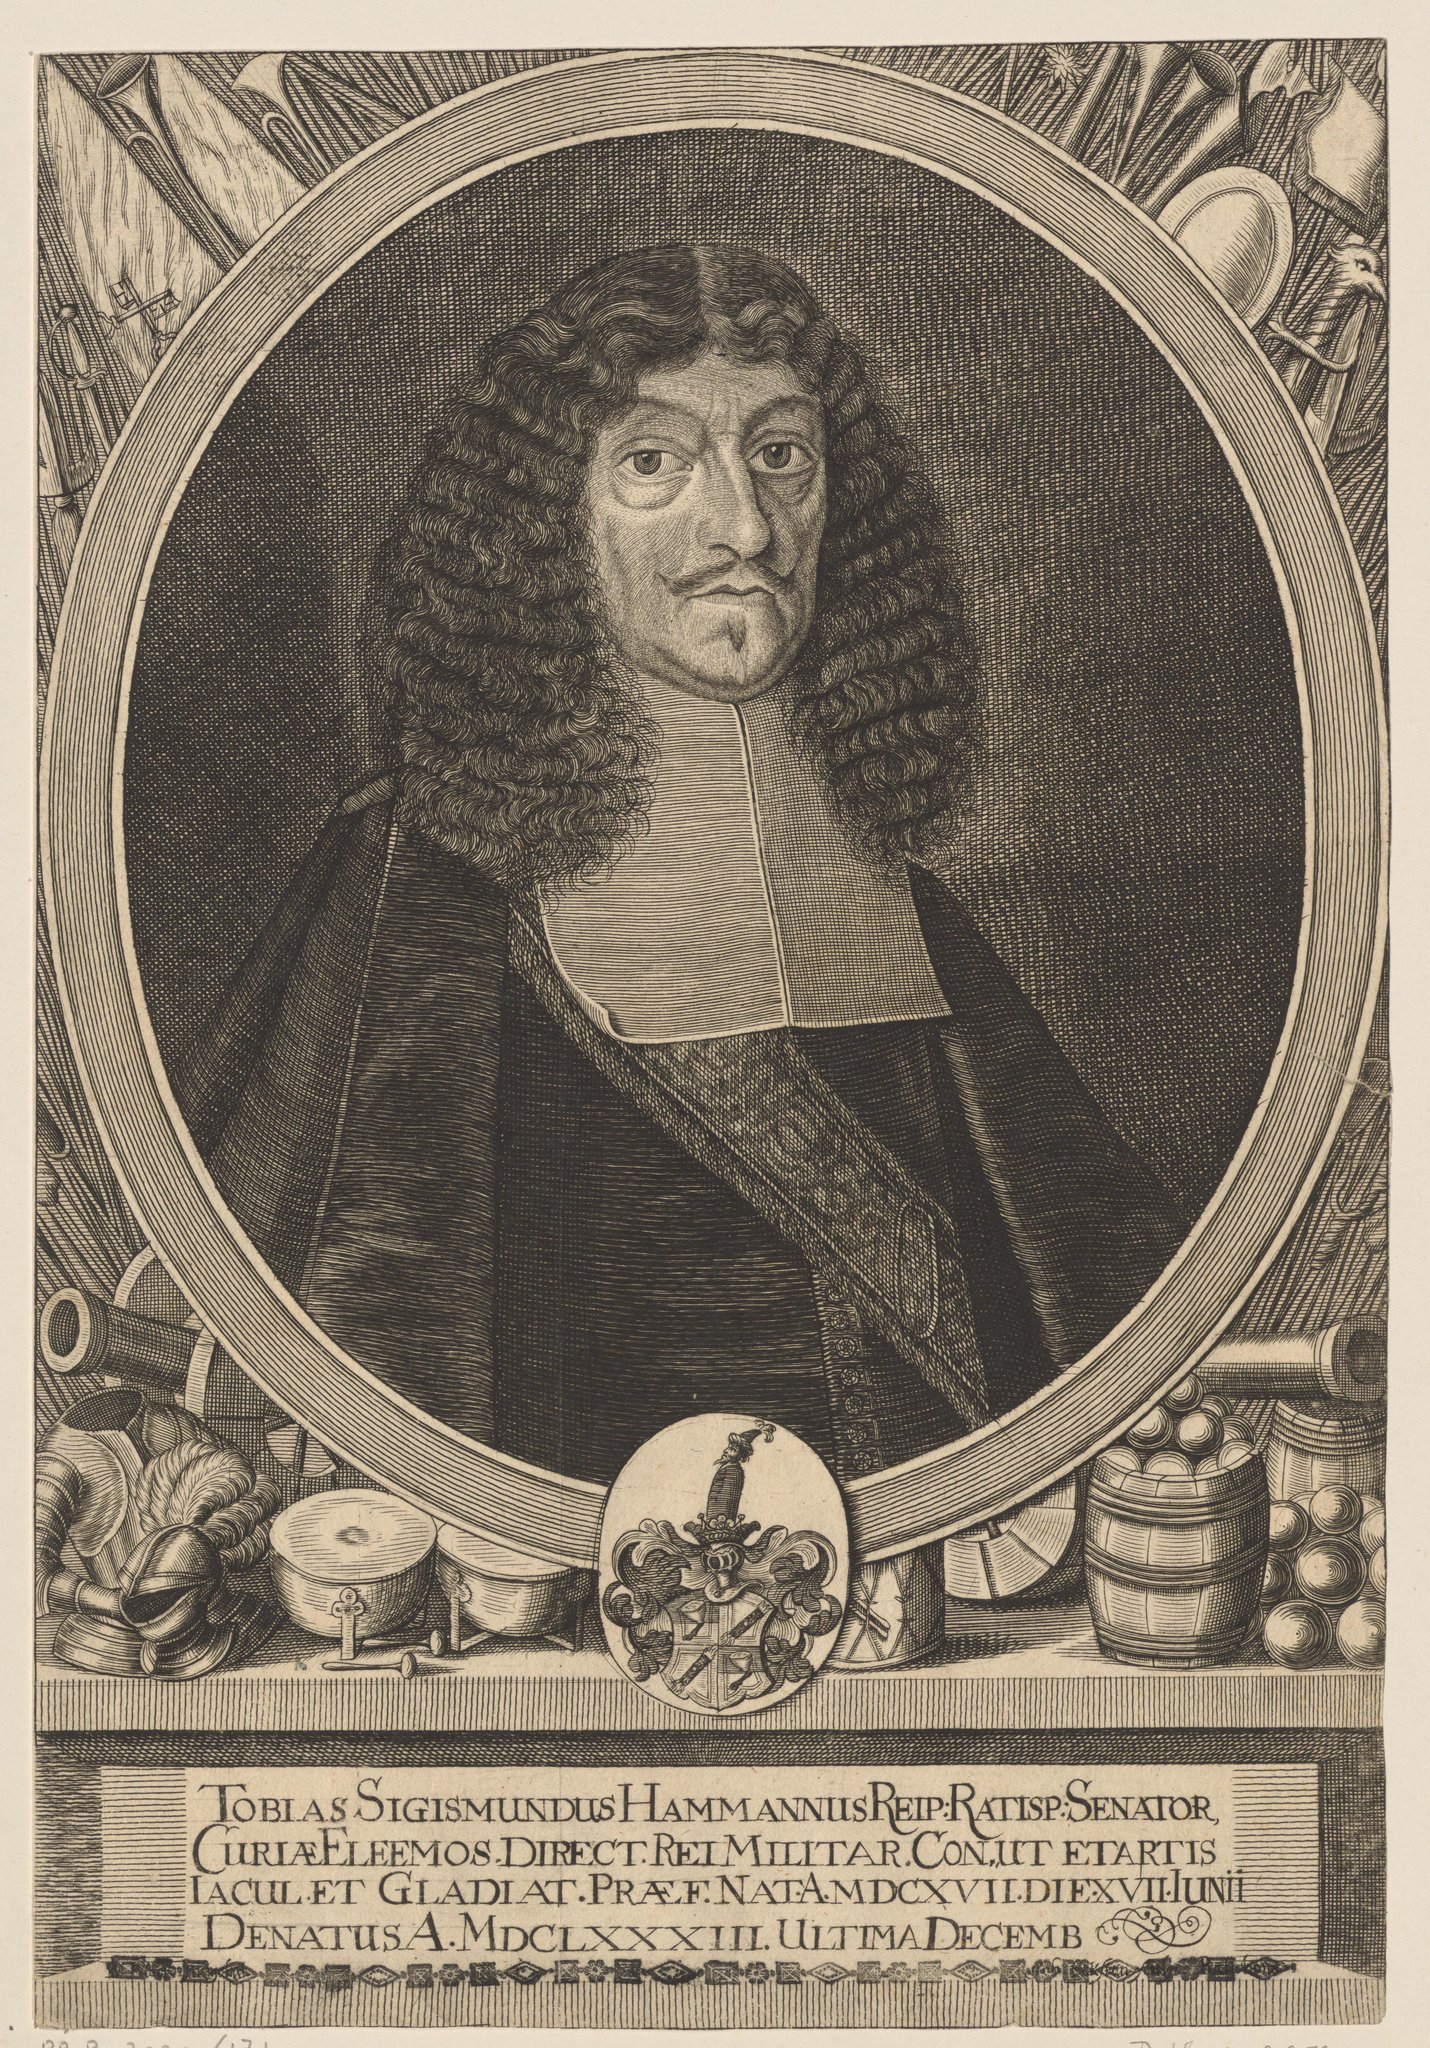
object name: print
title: Portret van Tobias Sigismund Hammann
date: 1683-1699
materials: paper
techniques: engraving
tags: armour, historical persons, armorial bearing, heraldry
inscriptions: collector's mark: Lugt 2233